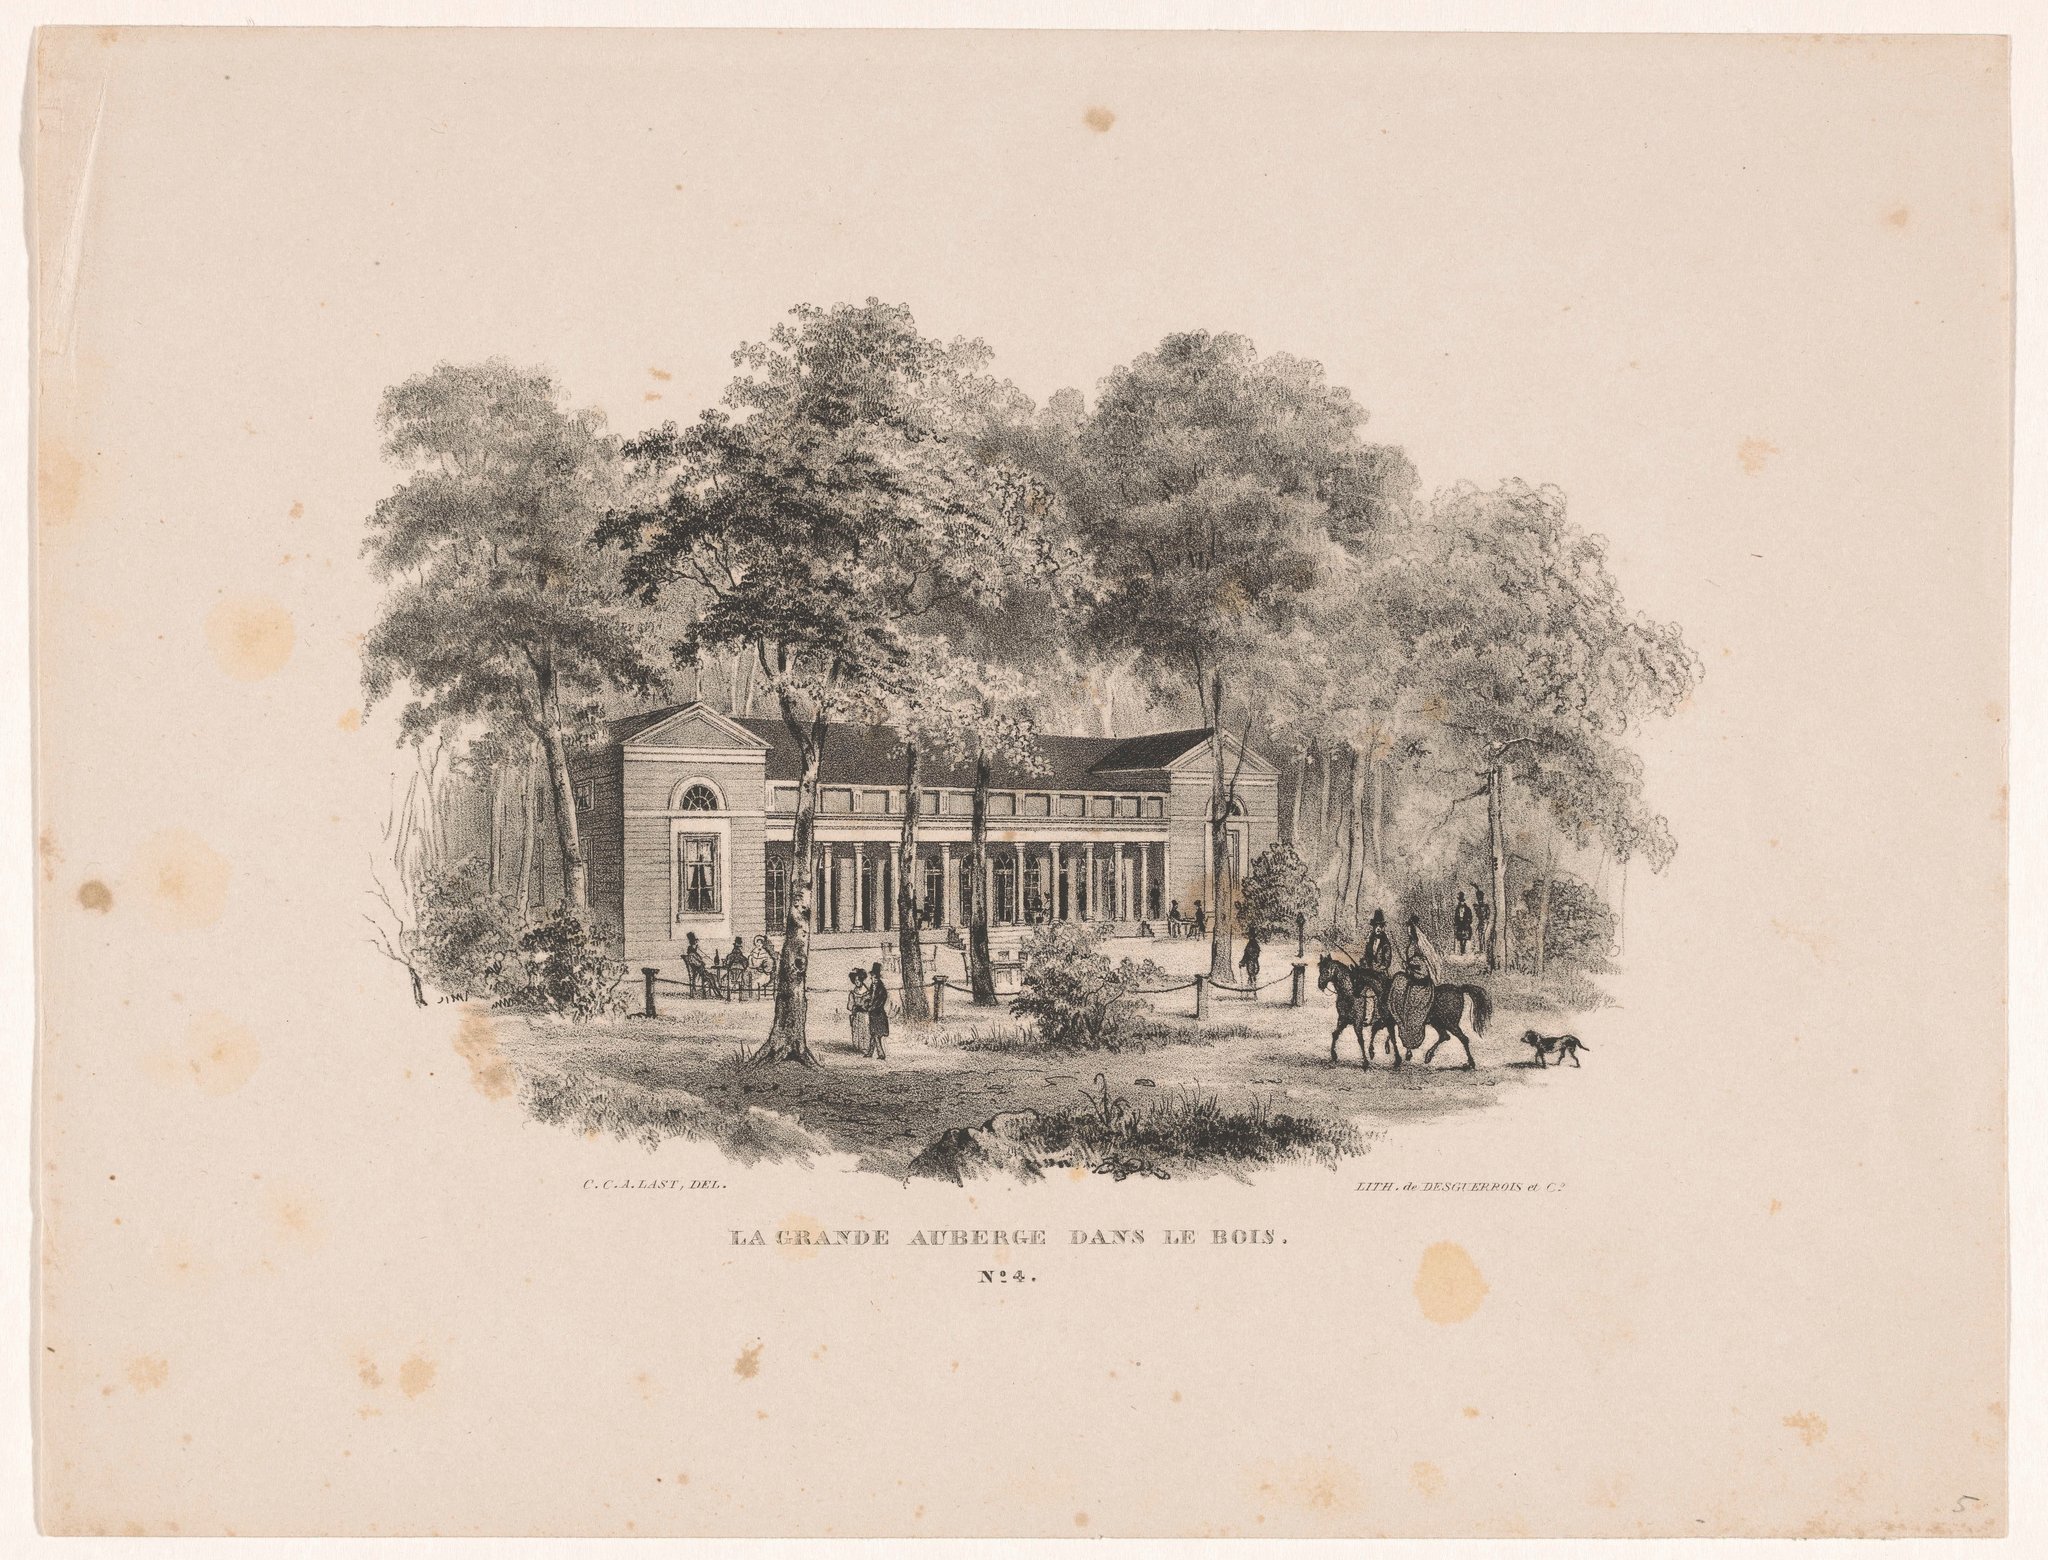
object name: print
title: Herberg in het Haagse bos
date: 1818-1876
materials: paper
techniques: lithograph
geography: amsterdam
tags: hotel, hostelry, inn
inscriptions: collector's mark: Lugt 2228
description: Maakt deel uit van een serie van in ieder geval 46 prenten. Zie: RP-P-1908-3436 t/m Zie: RP-P-1908-3443.